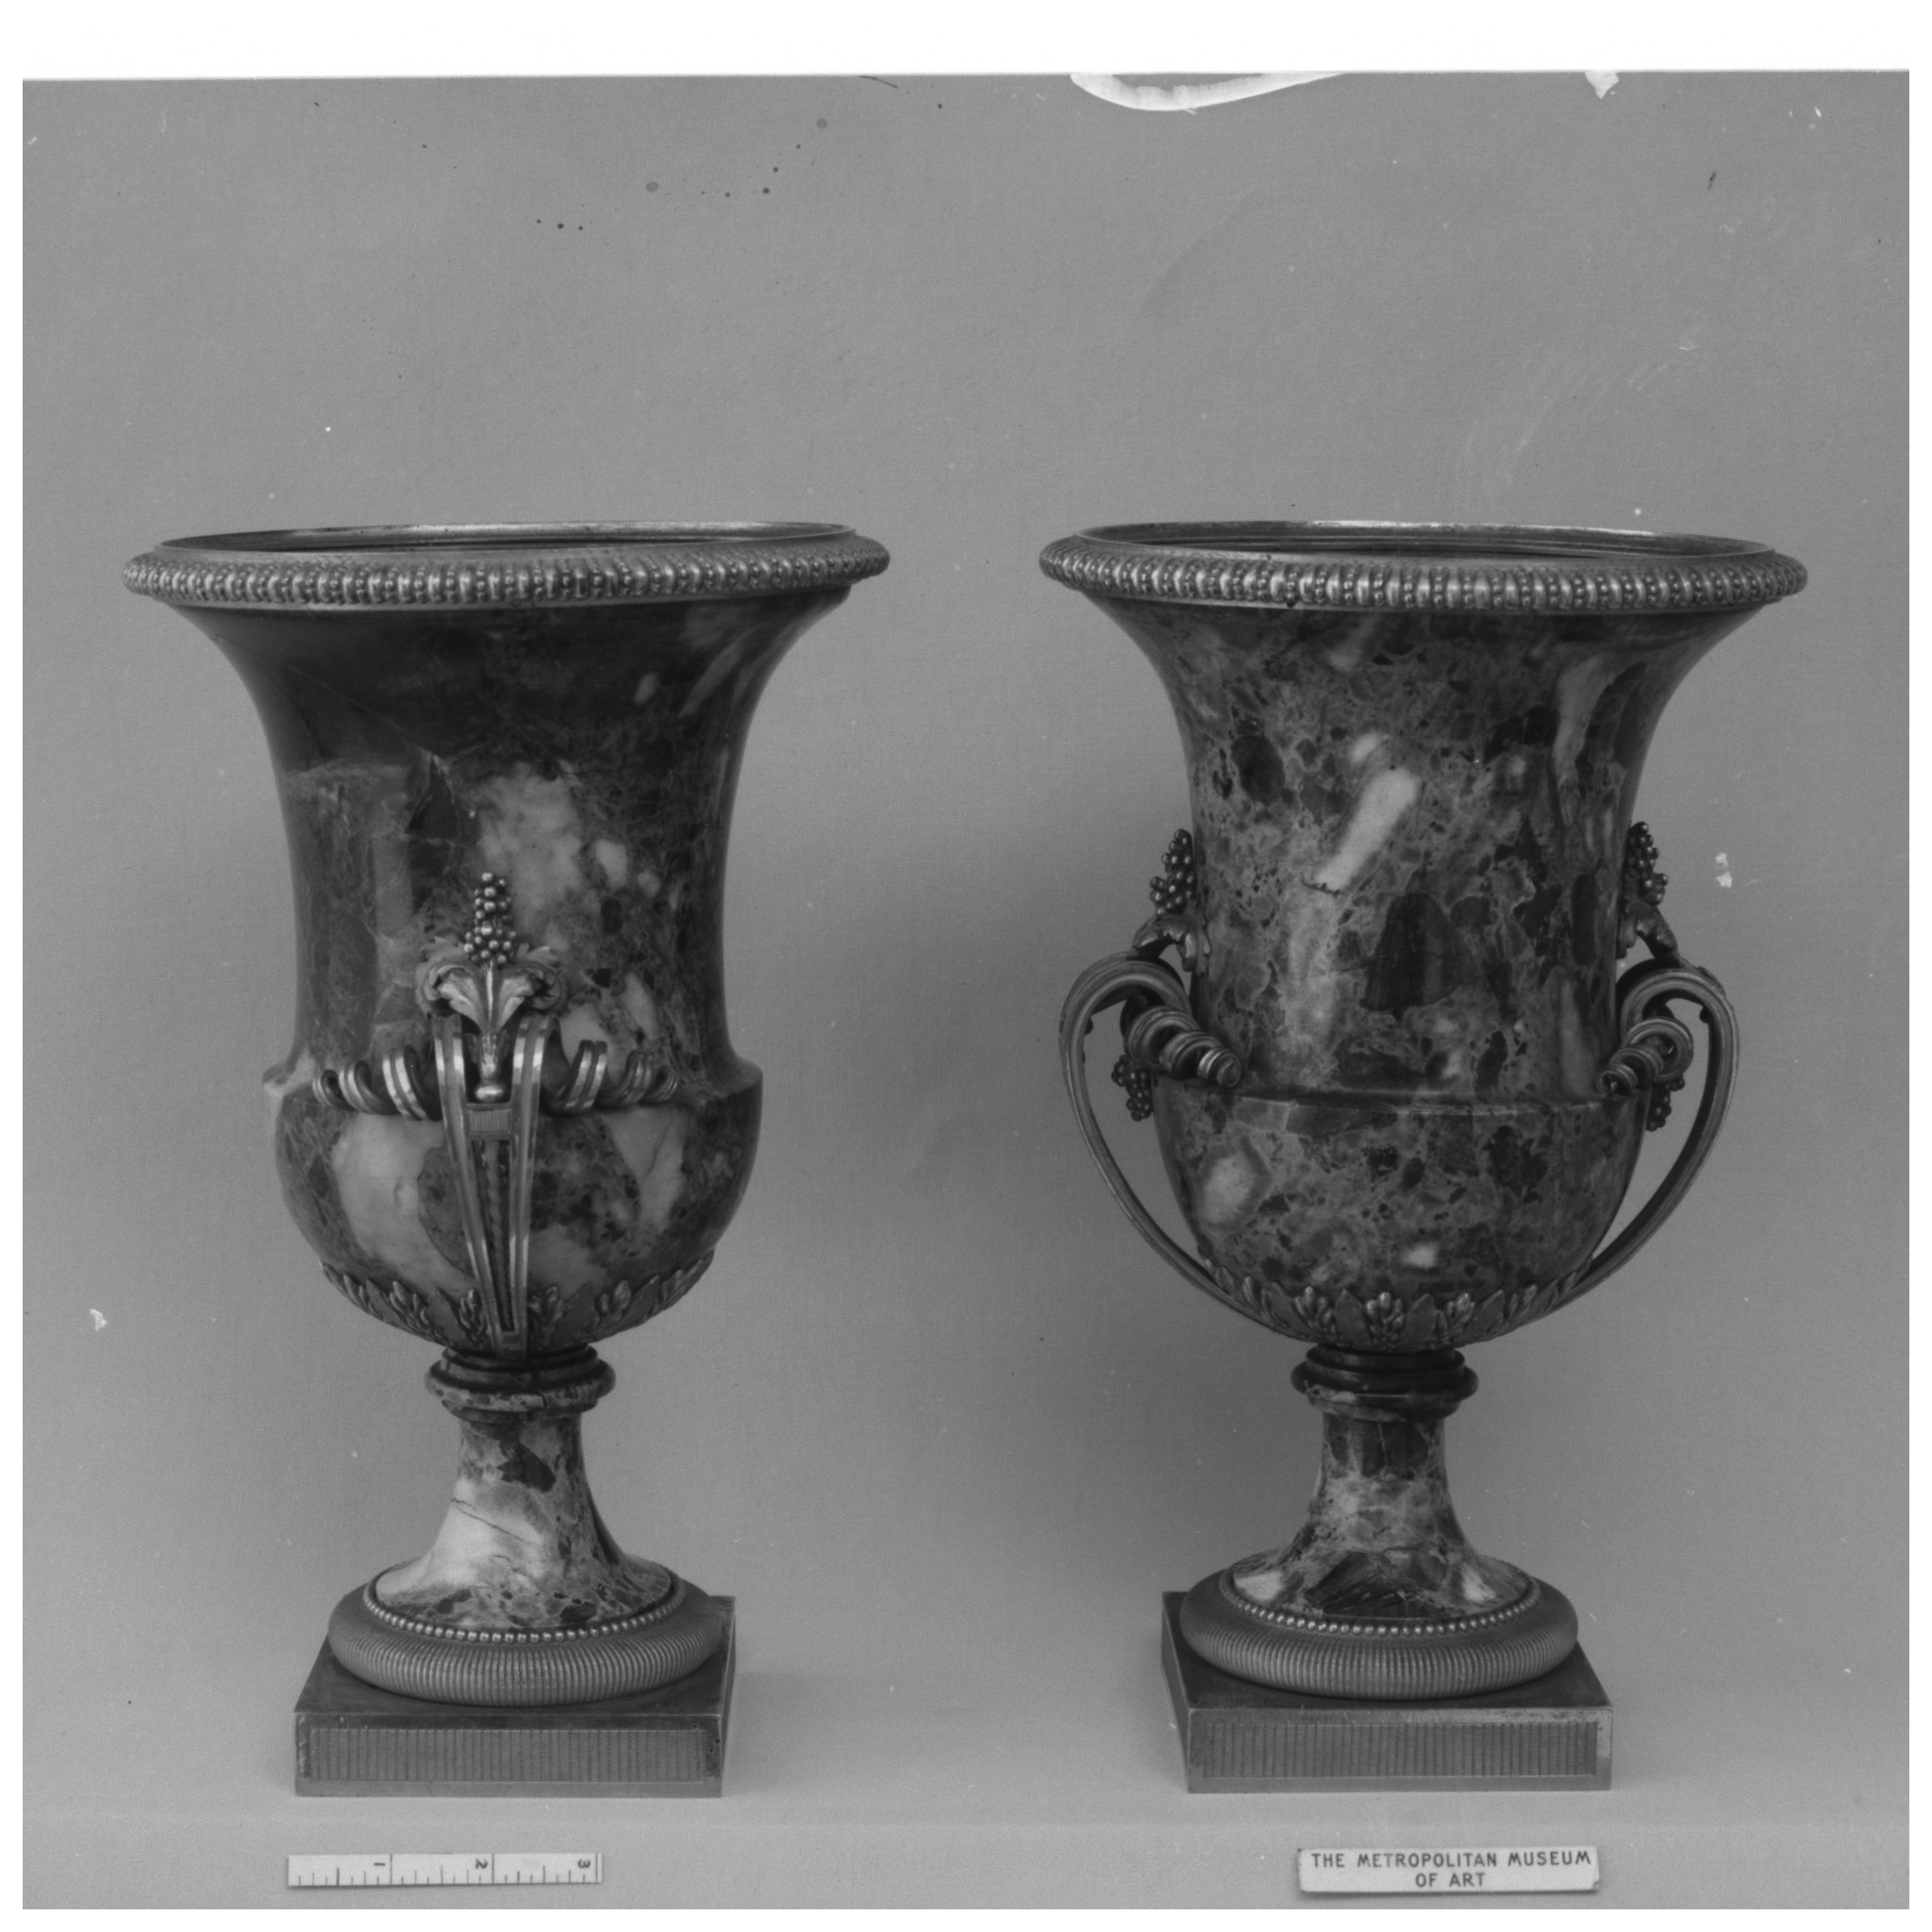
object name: vase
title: Vase (one of a pair)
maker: pierre gouthière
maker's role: maker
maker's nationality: french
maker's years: 1732-1814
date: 1701-1800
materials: gilt bronze, marble